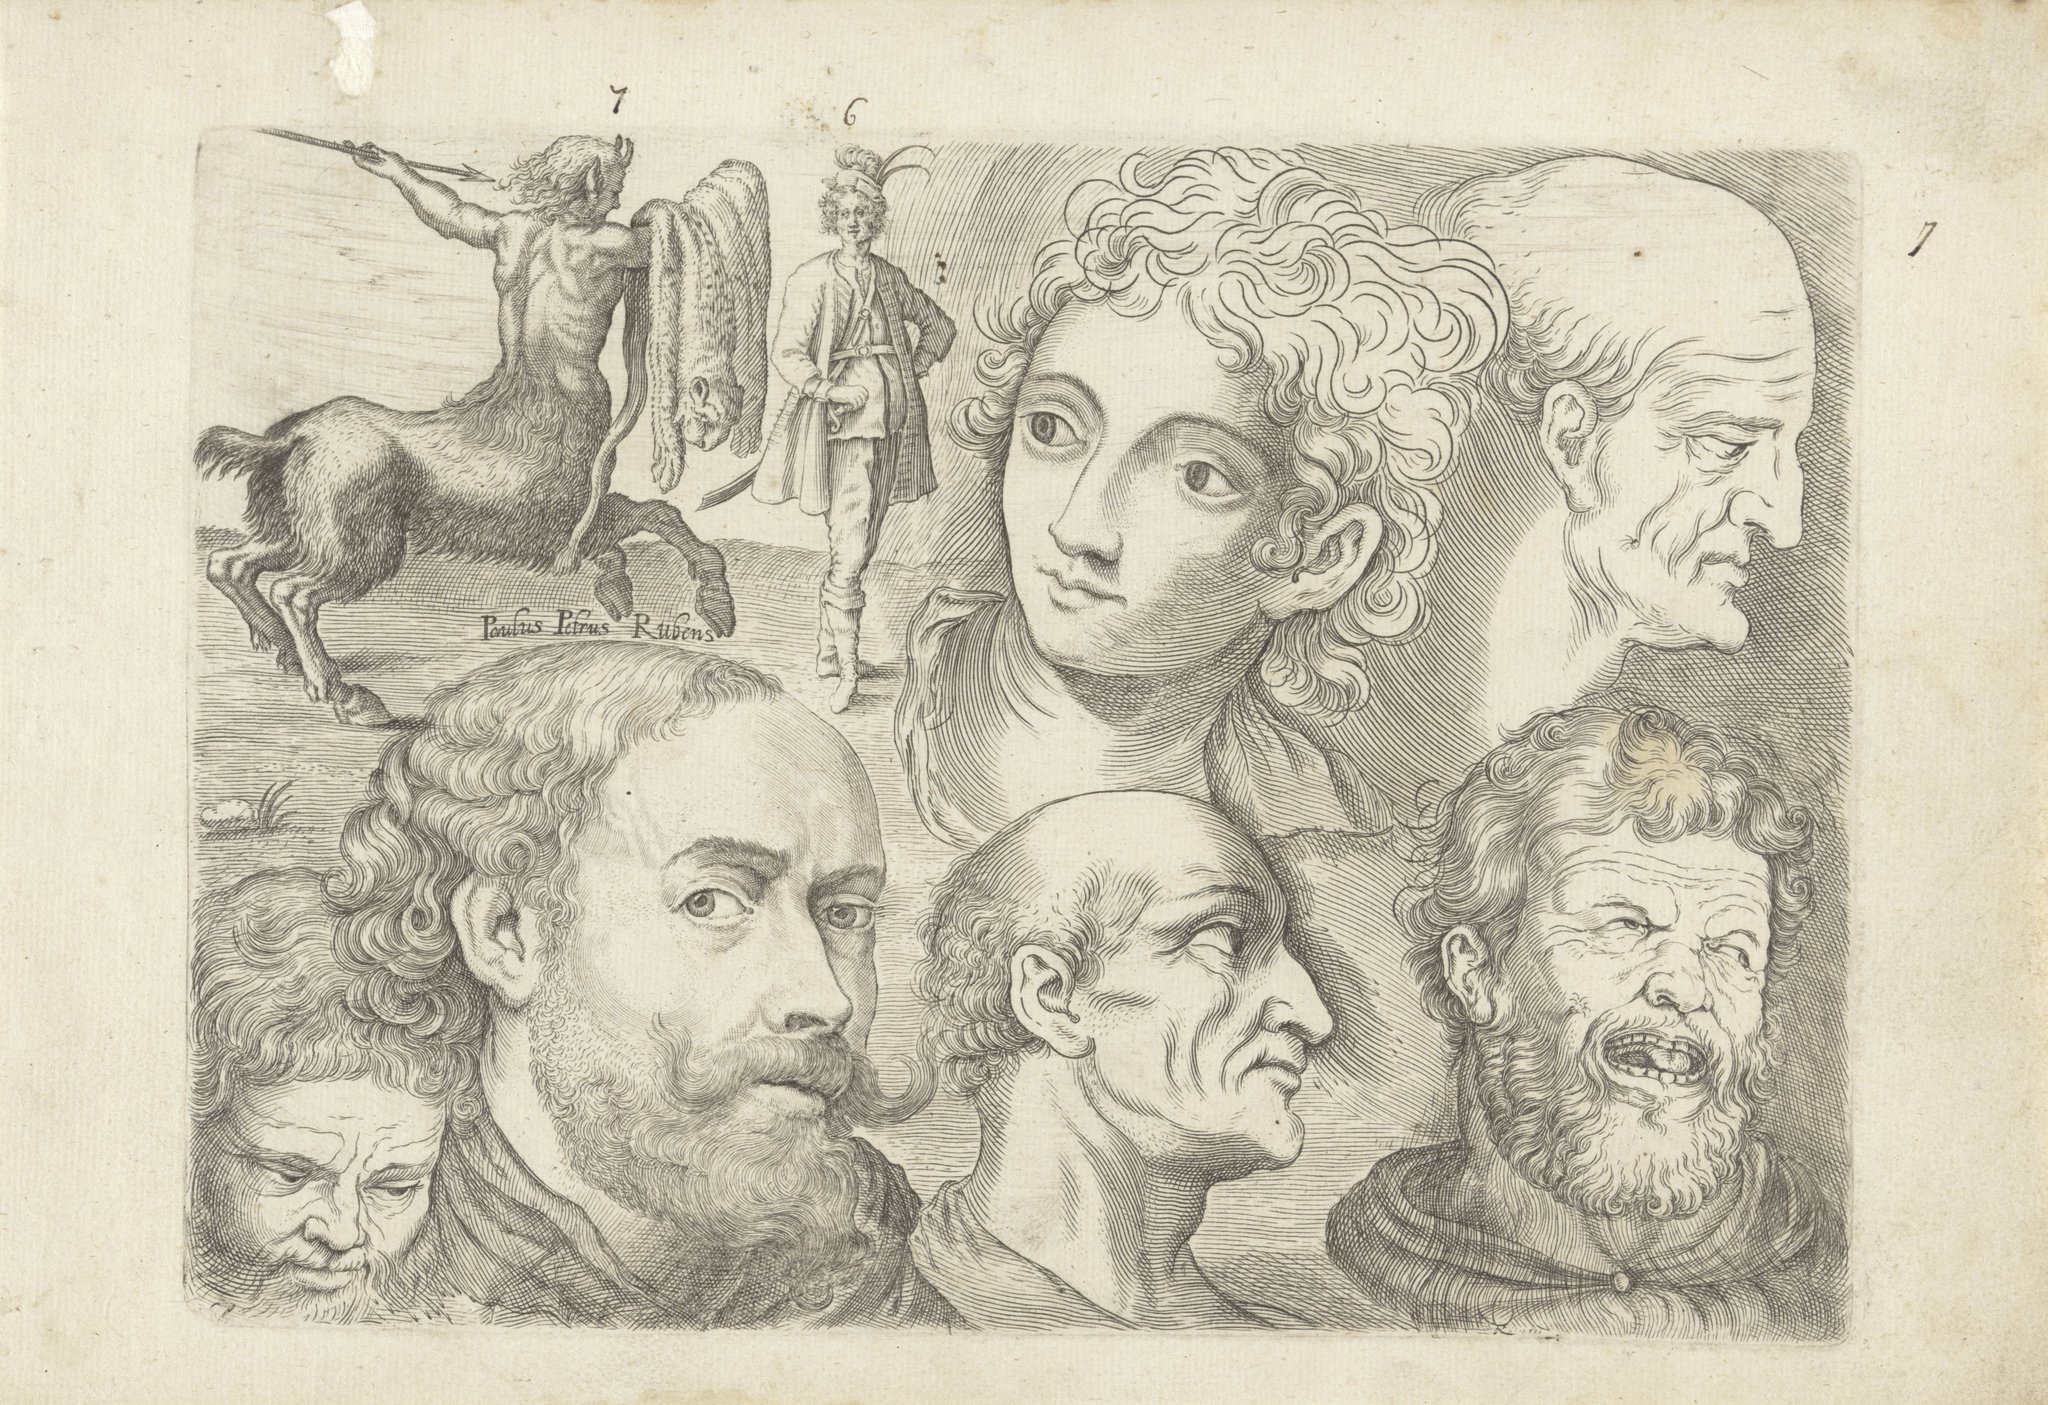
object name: print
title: Studieblad met tekenvoorbeelden: centaur, staande figuur en koppen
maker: michael snijders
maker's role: print maker, publisher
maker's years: 1586-1672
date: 1610-1672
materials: paper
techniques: engraving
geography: antwerp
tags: antwerp, painter, peter paul rubens, head (human), centaurs, model-books ~ implements of painter, portrait, self-portrait of artist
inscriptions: collector's mark: Lugt 2228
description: Zevende prent uit een serie tekenvoorbeelden van onbekende omvang. Studieblad met linksboven een centaur met speer en leeuwenvel. Daarnaast een staande figuur. Verder verschillende mannenkoppen, waaronder links het portret van Peter Paul Rubens.